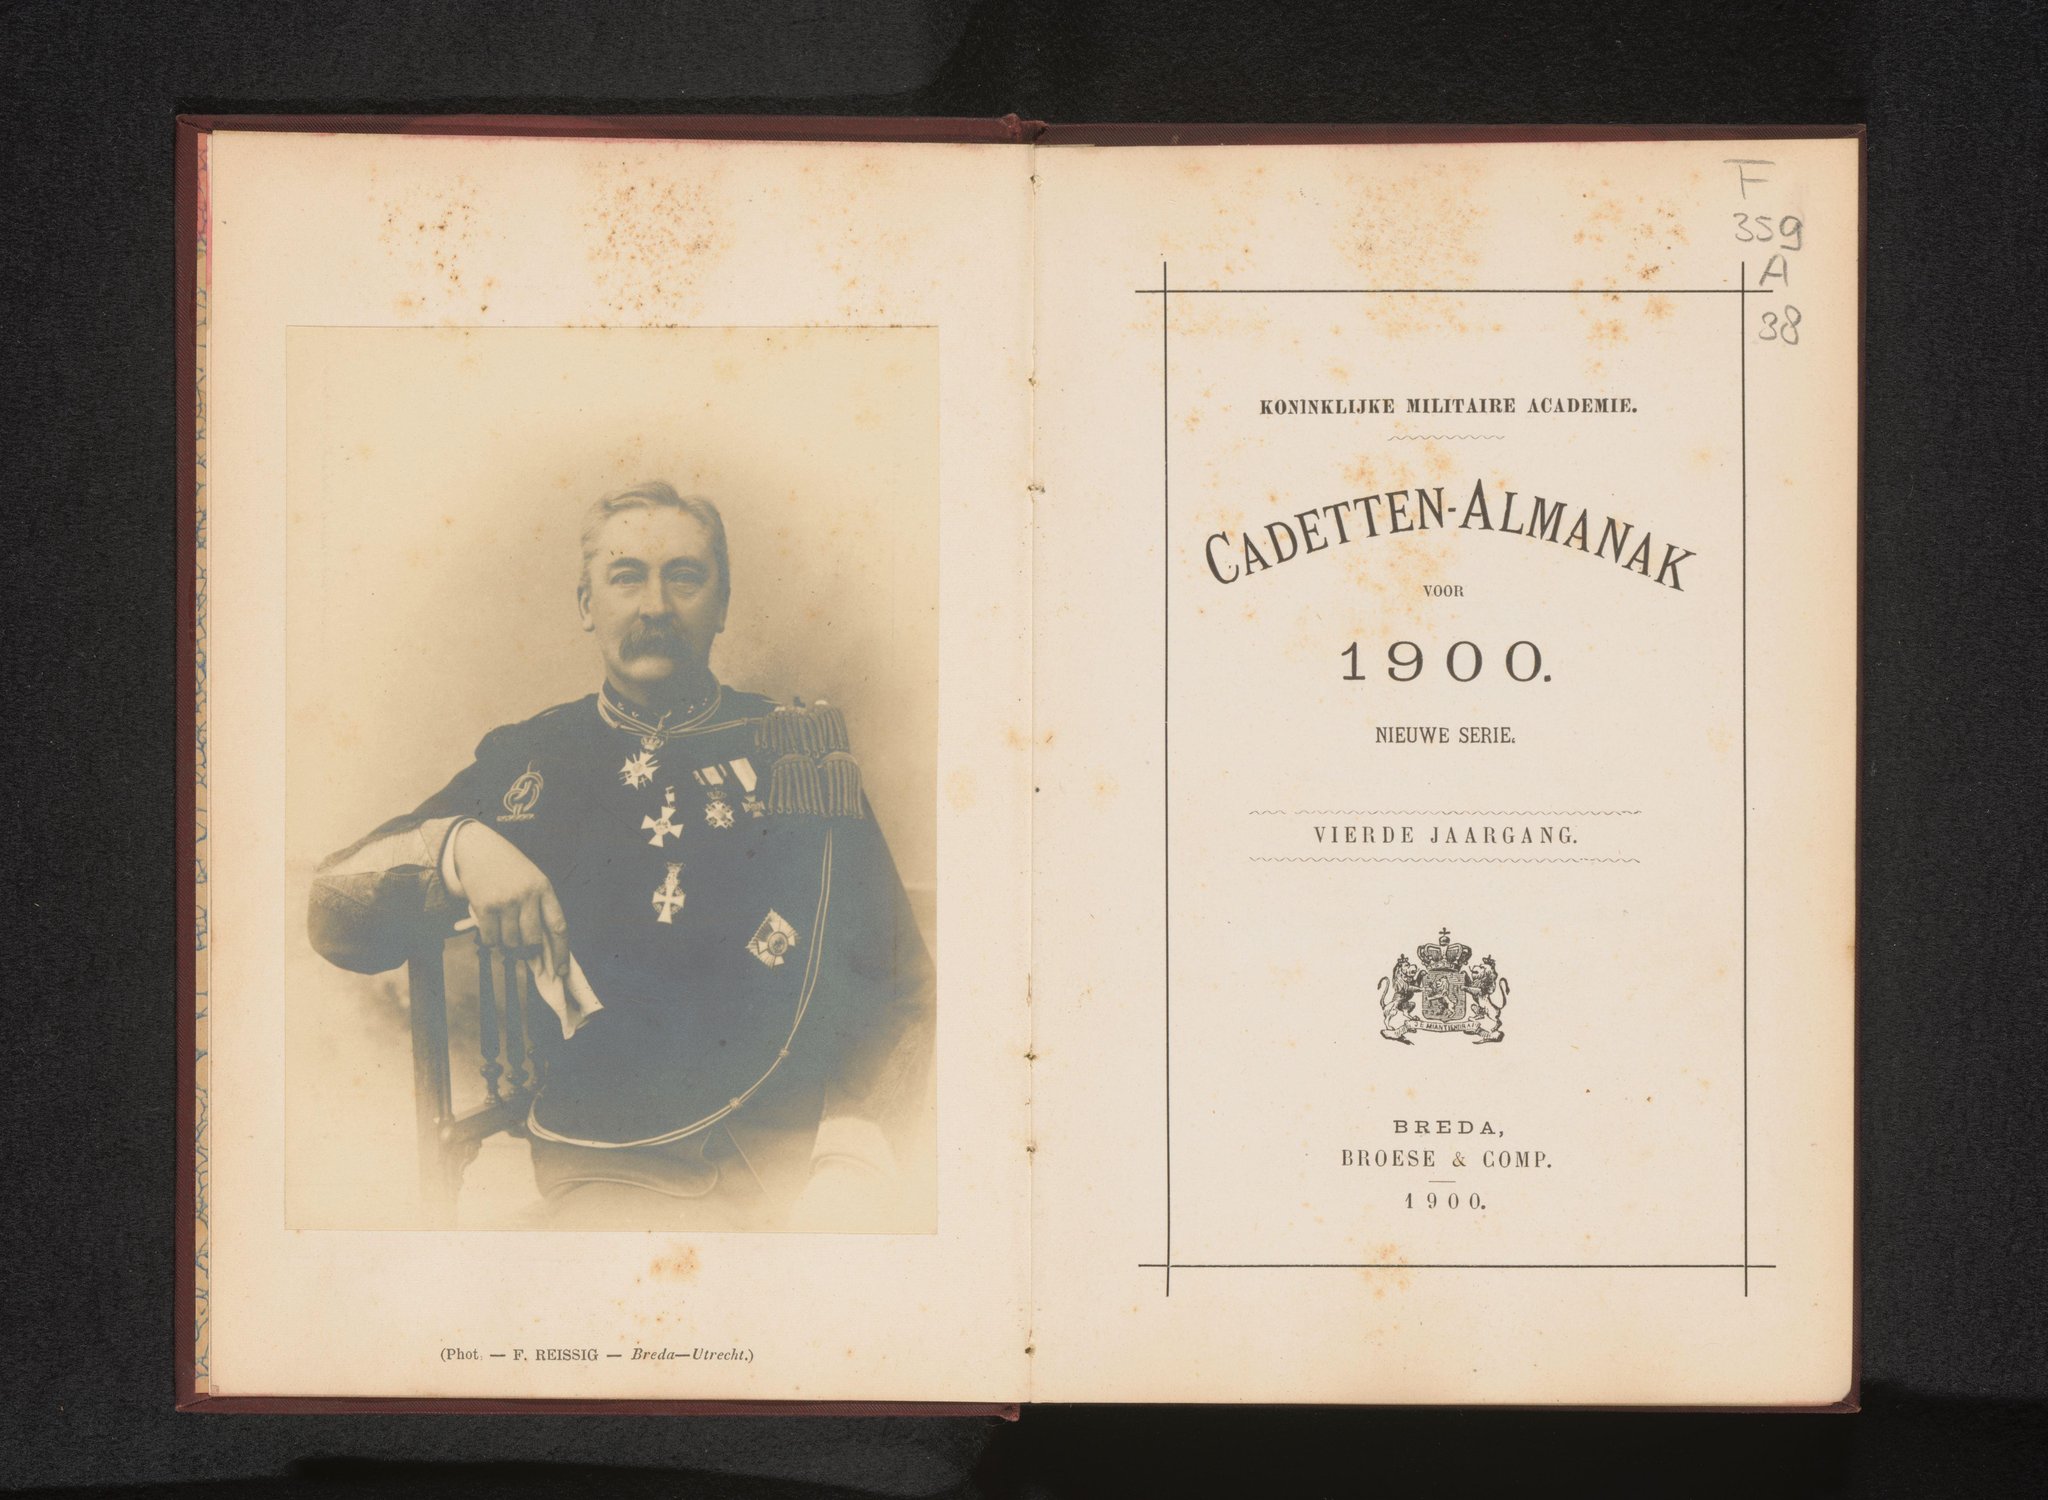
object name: page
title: Portret van een onbekende hooggeplaatste militair van de Koninklijke Militaire Academie in Breda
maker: franz reissig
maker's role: fotograaf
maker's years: 1852-1936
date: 1895-1900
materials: photographic support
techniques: gelatin silver print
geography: breda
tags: officer, historical persons not known by name